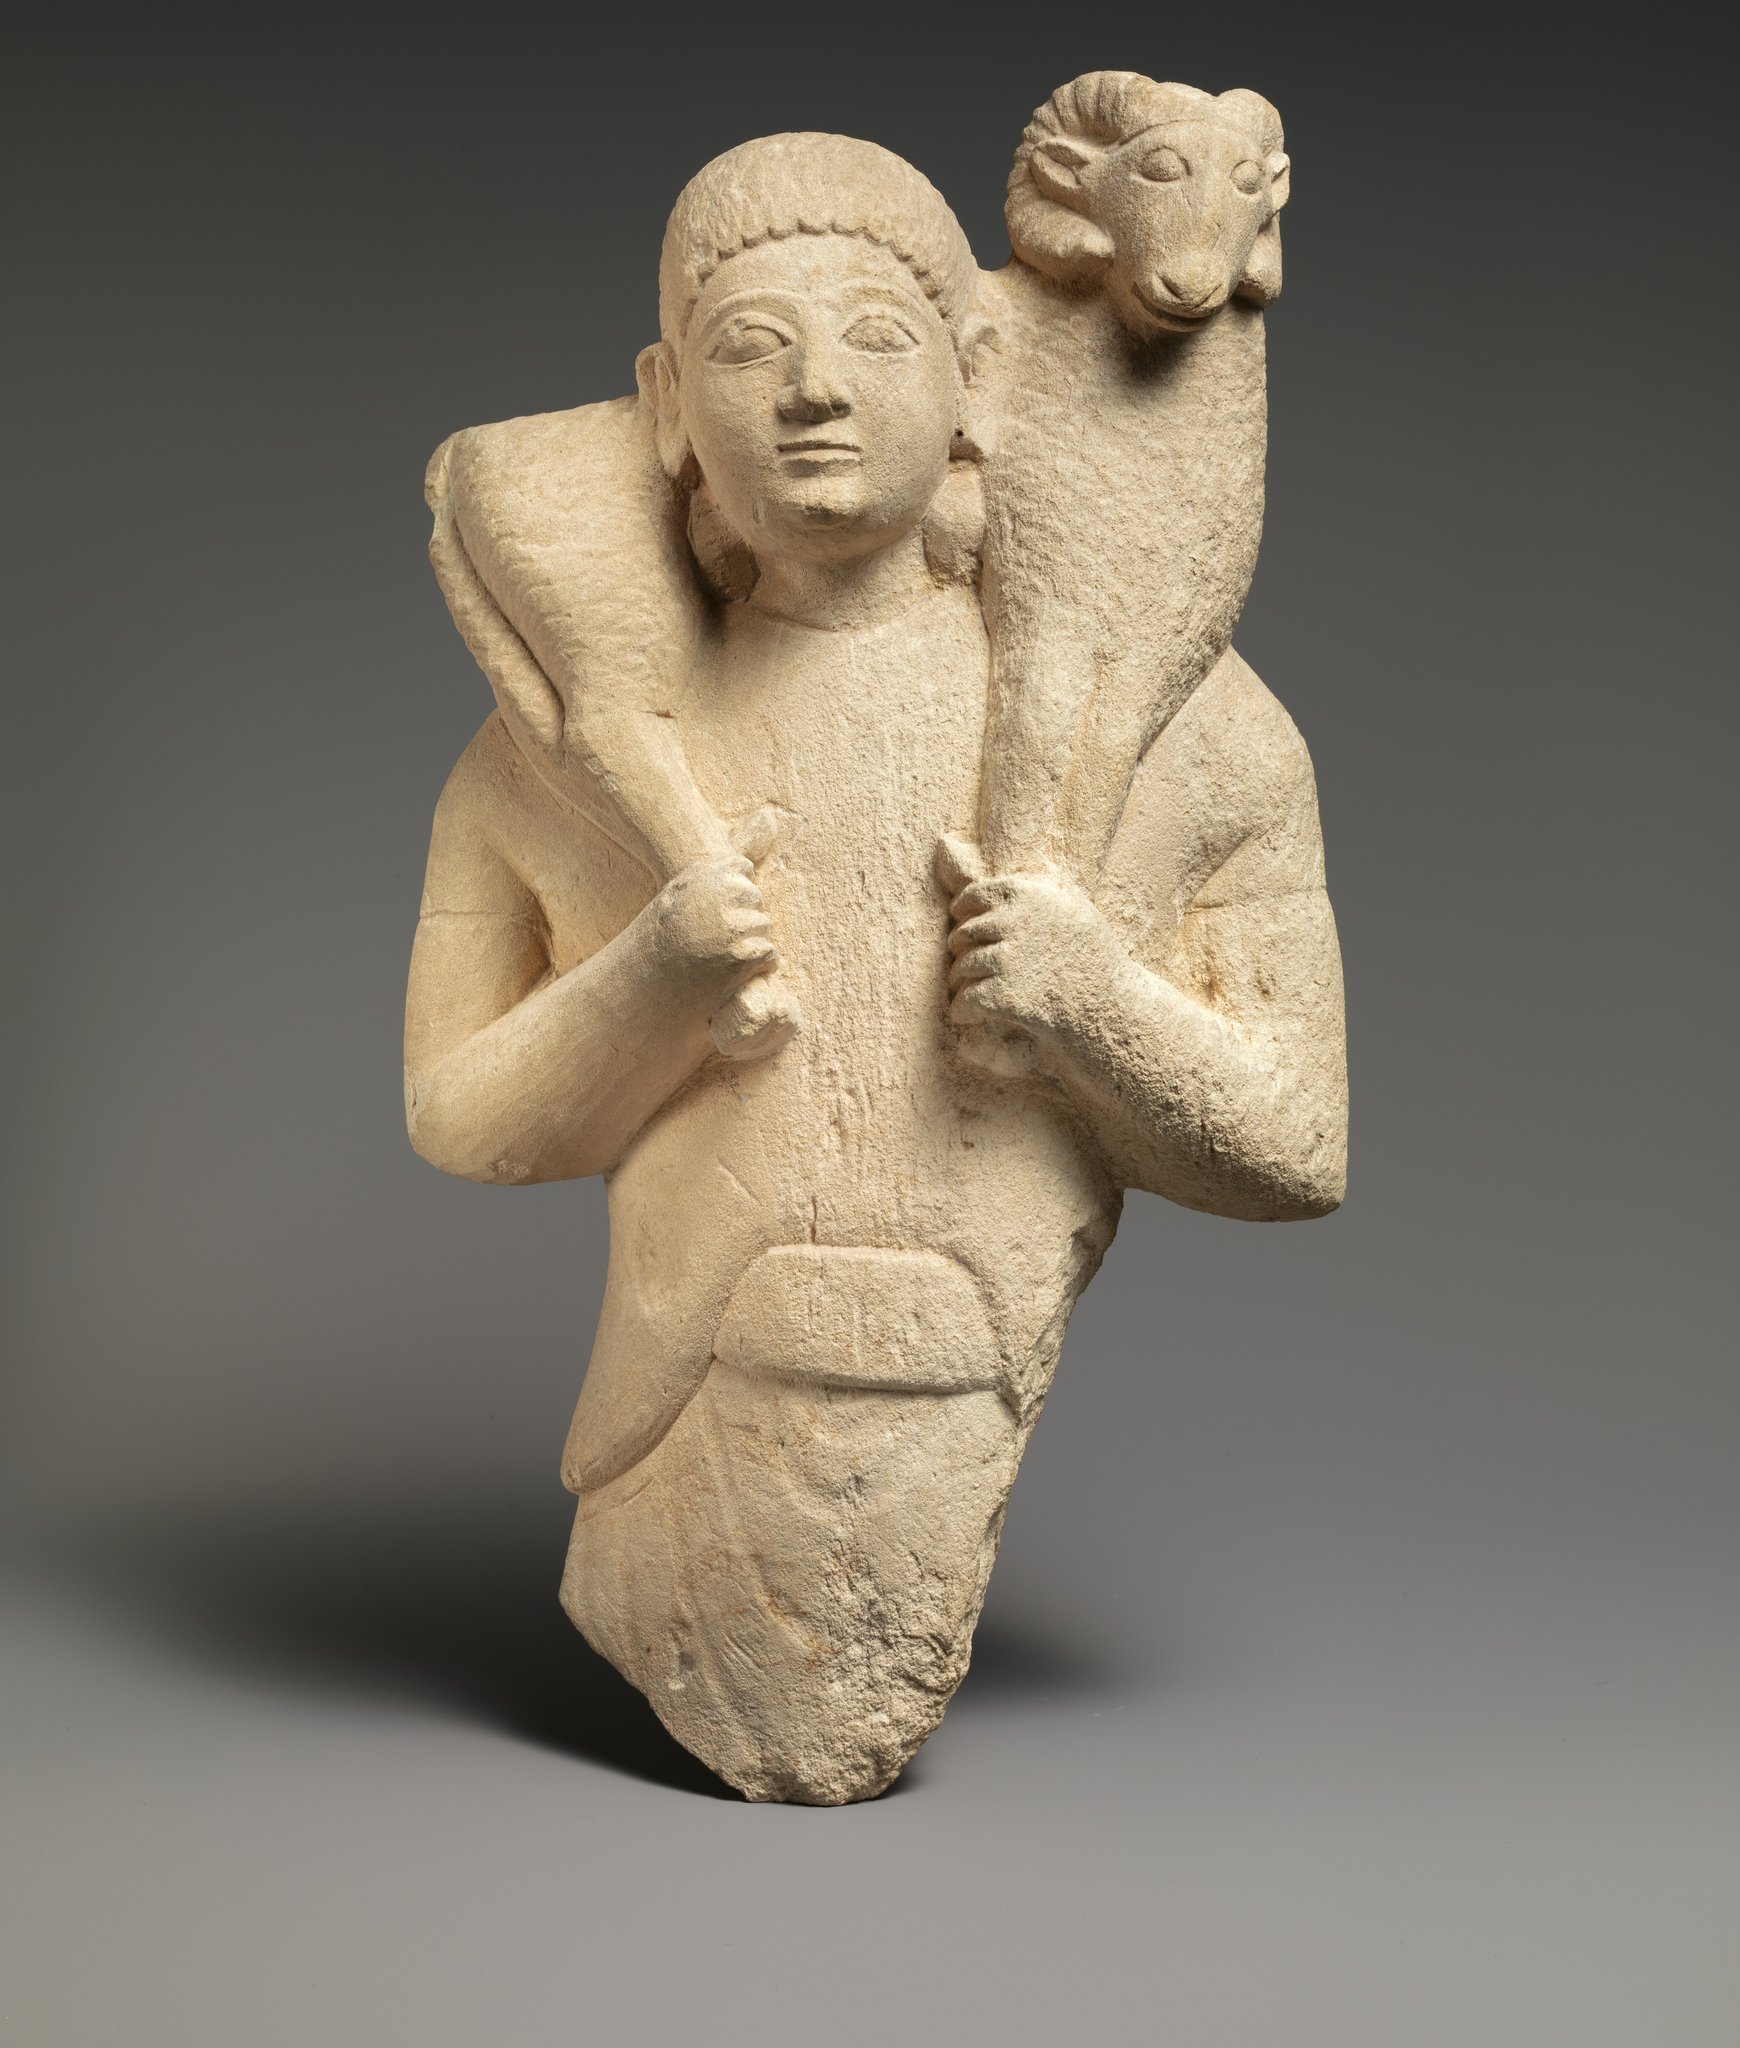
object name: statuette of a kriophoros, fragmentary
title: Limestone ram-bearer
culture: cypriot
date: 575-551 BCE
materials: limestone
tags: men,rams